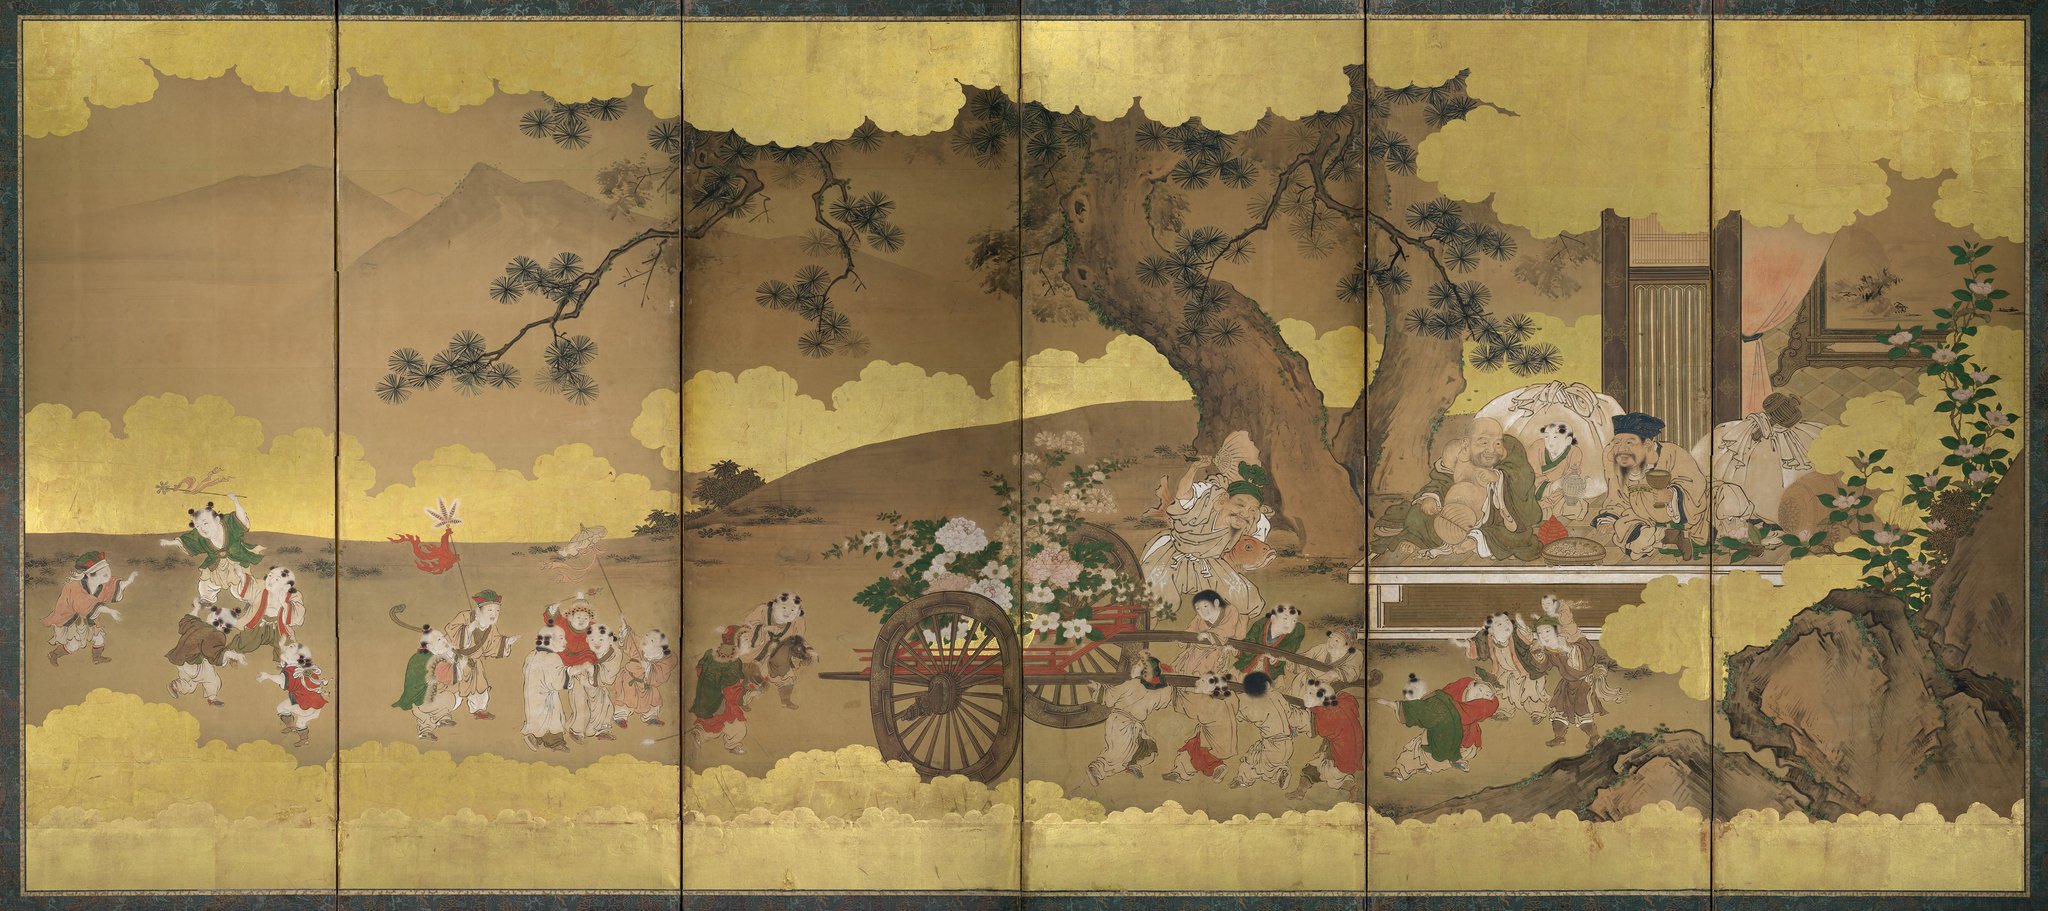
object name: screen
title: Seven Gods of Good Fortune and Chinese Children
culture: japanese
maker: kano chikanobu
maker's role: artist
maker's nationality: japanese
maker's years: 1660-1728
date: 1601-1800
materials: gilt, gold, ink, panel, paper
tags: human figures,children,men,peonies,carts